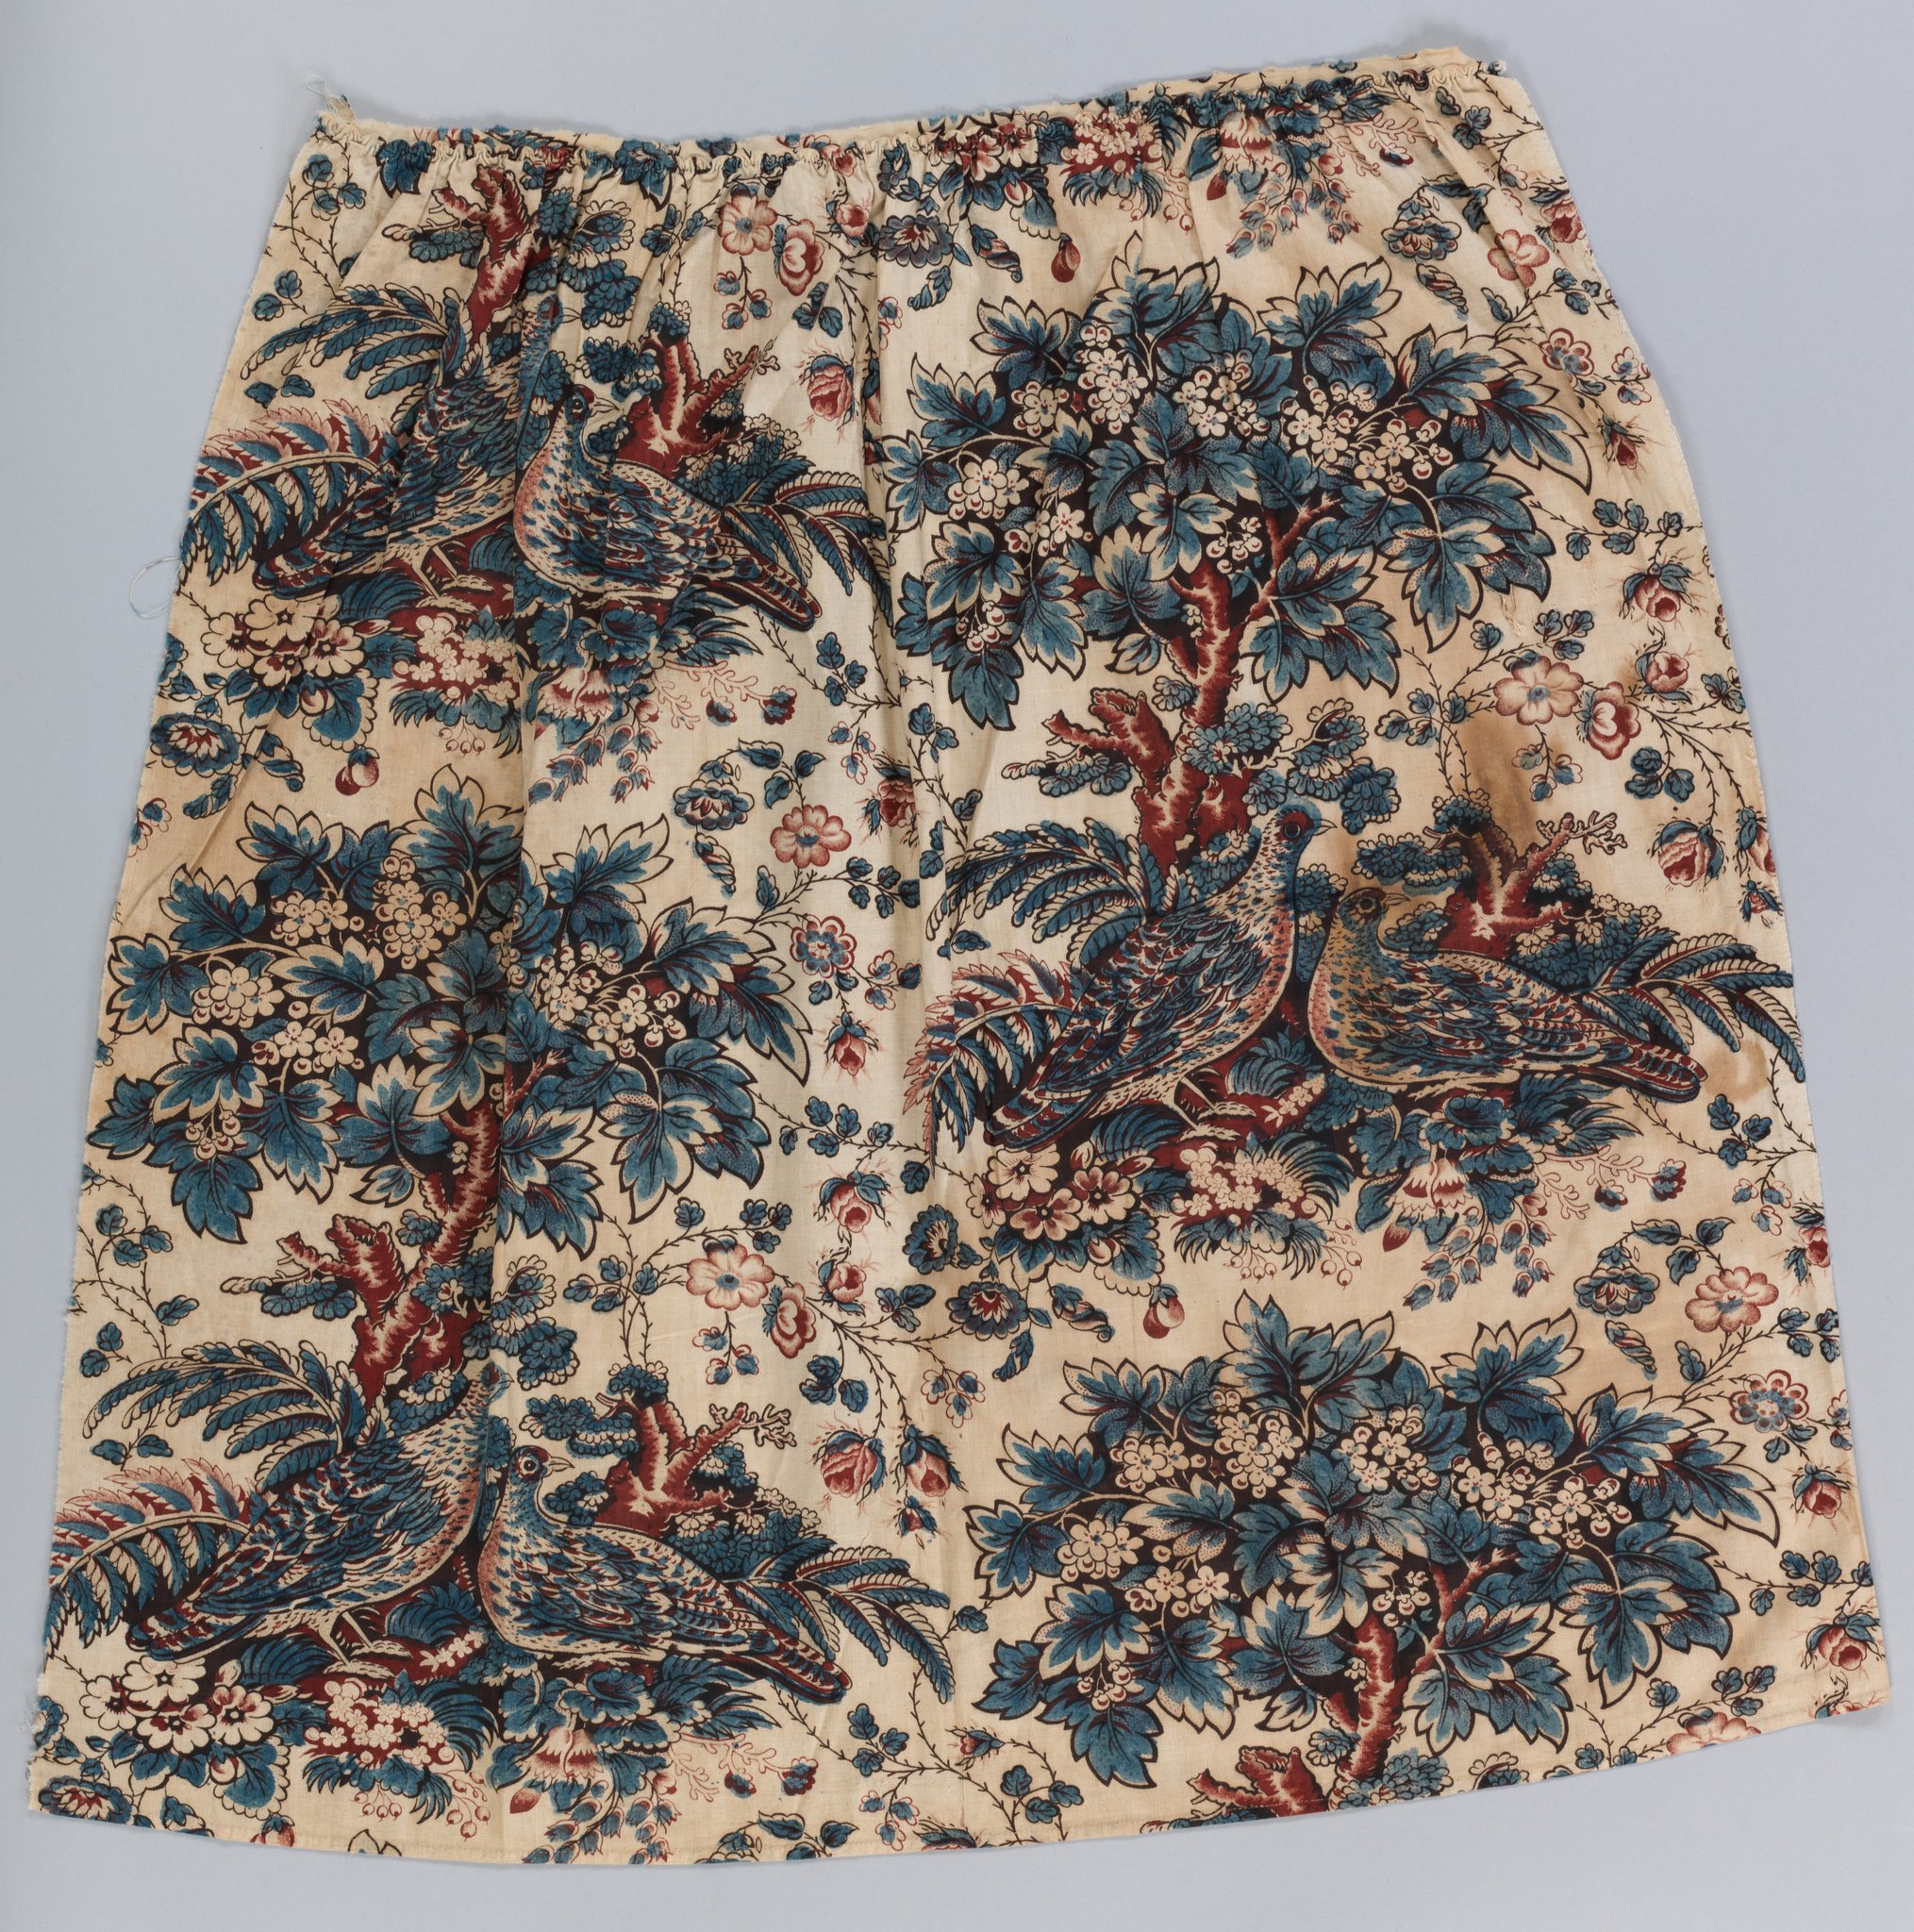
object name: bedskirt fragment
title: Section of bedskirt printed with game birds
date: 1830-1839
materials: cotton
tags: birds,flowers,leaves,trees